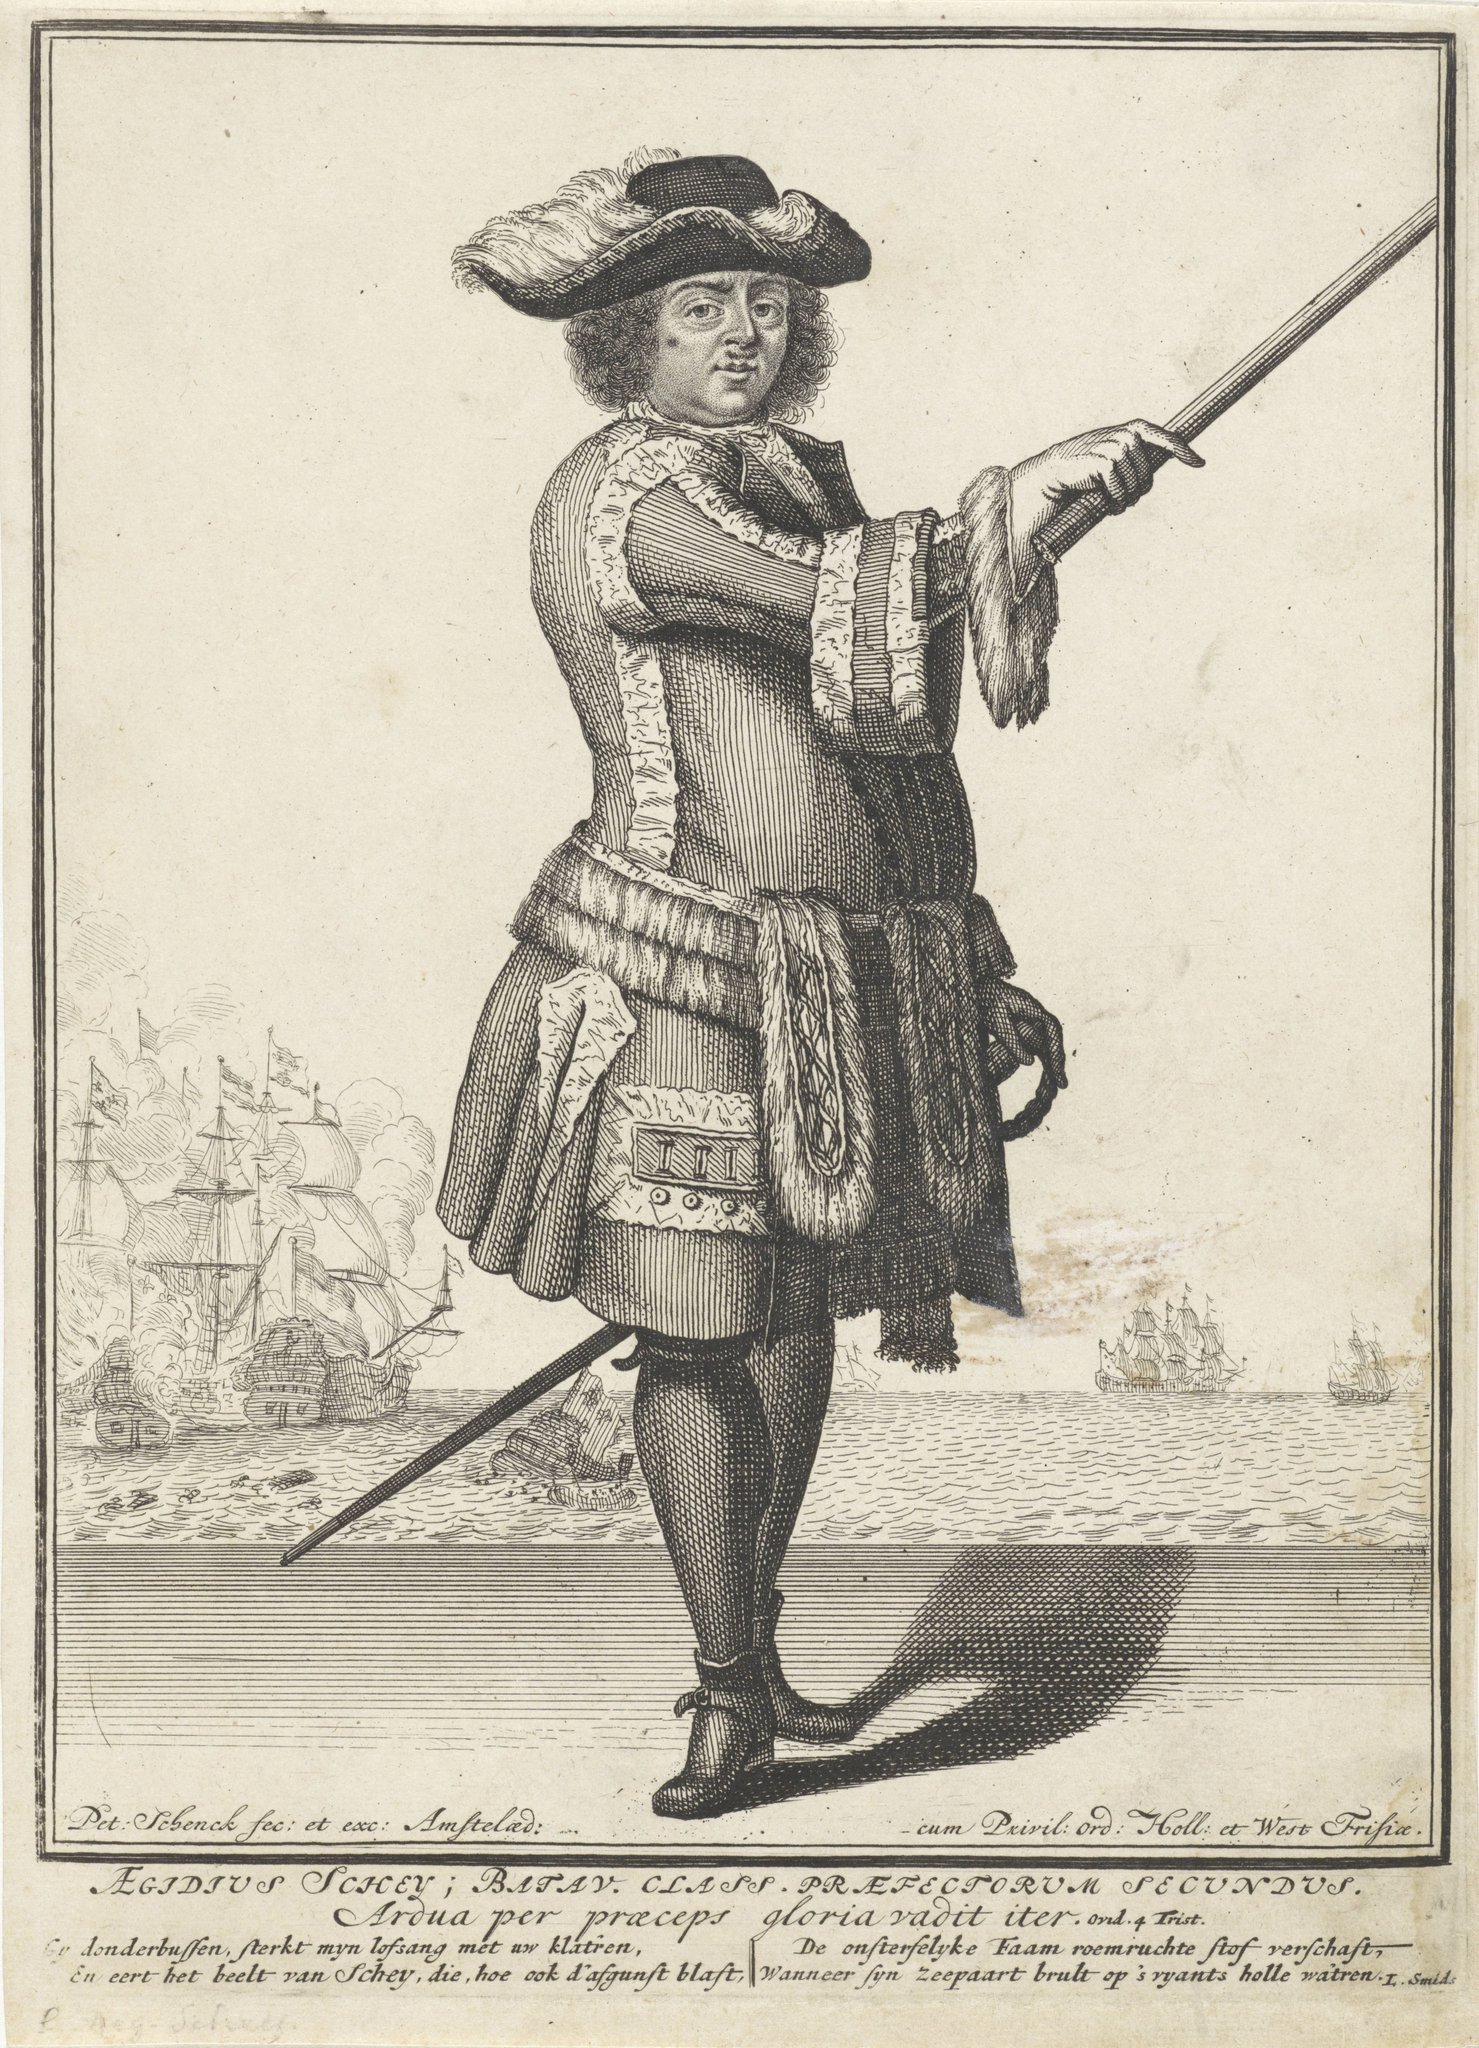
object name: costume print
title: Portret van Gilles Schey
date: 1675-1711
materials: paper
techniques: engraving, etching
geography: amsterdam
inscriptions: collector's mark: Lugt 2228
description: Portret van admiraal Gilles Schey. In zijn hand de aanvoerderstaf en op de achtergrond een zeeslag.